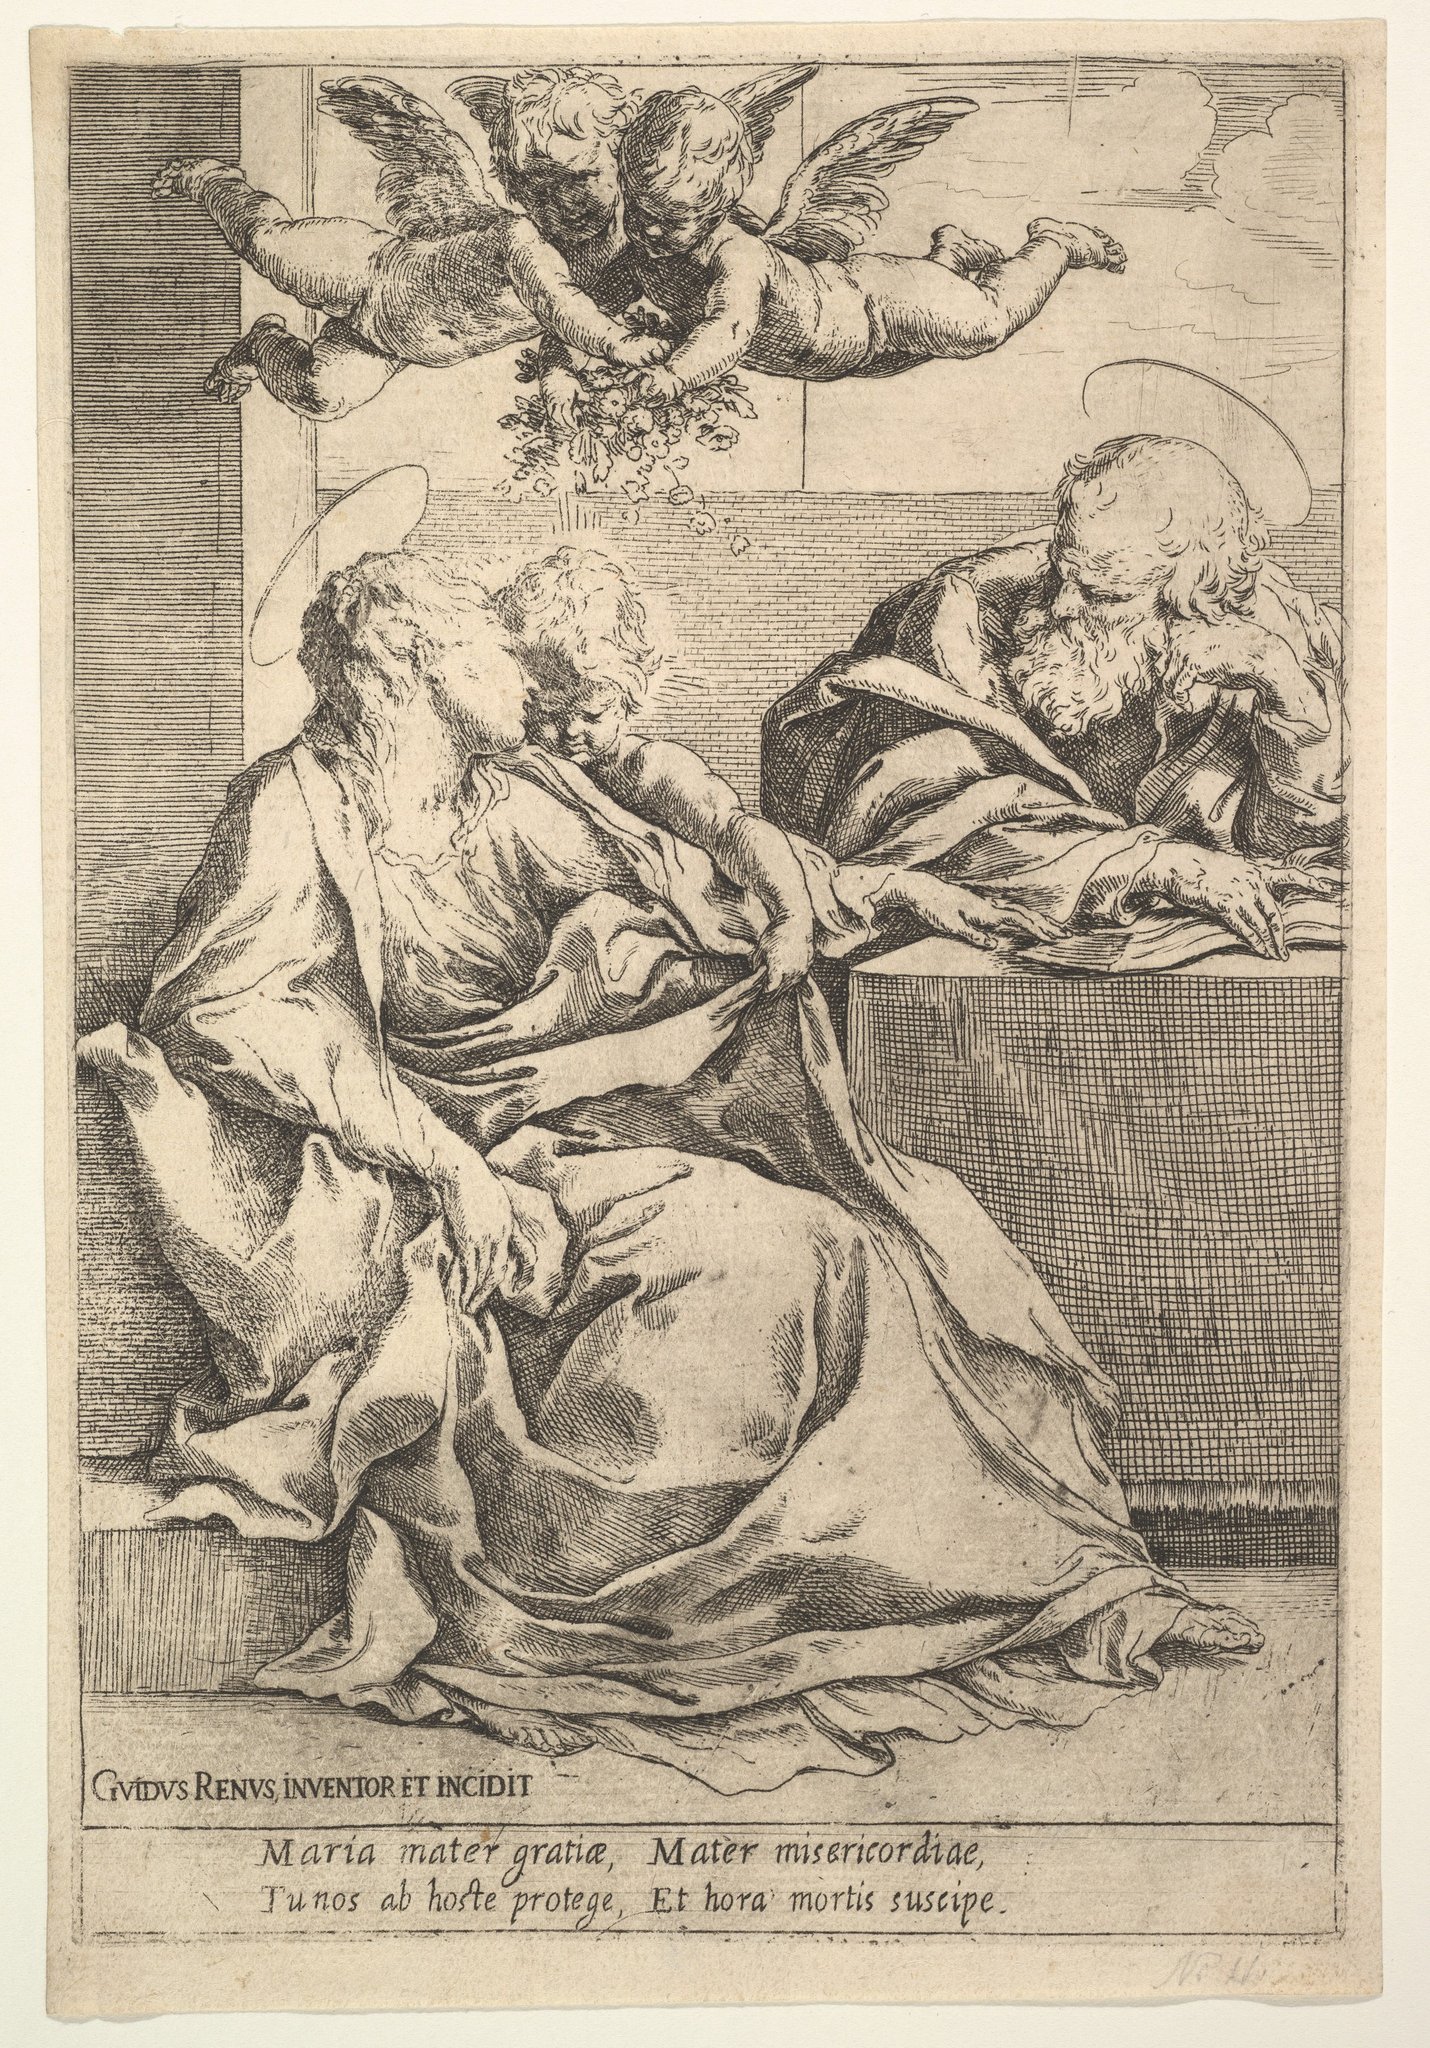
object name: print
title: The Holy Family with Two Angels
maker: guido reni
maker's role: artist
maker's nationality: italian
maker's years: 1575-1642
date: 1575-1642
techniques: etching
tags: holy family,madonna and child,saints